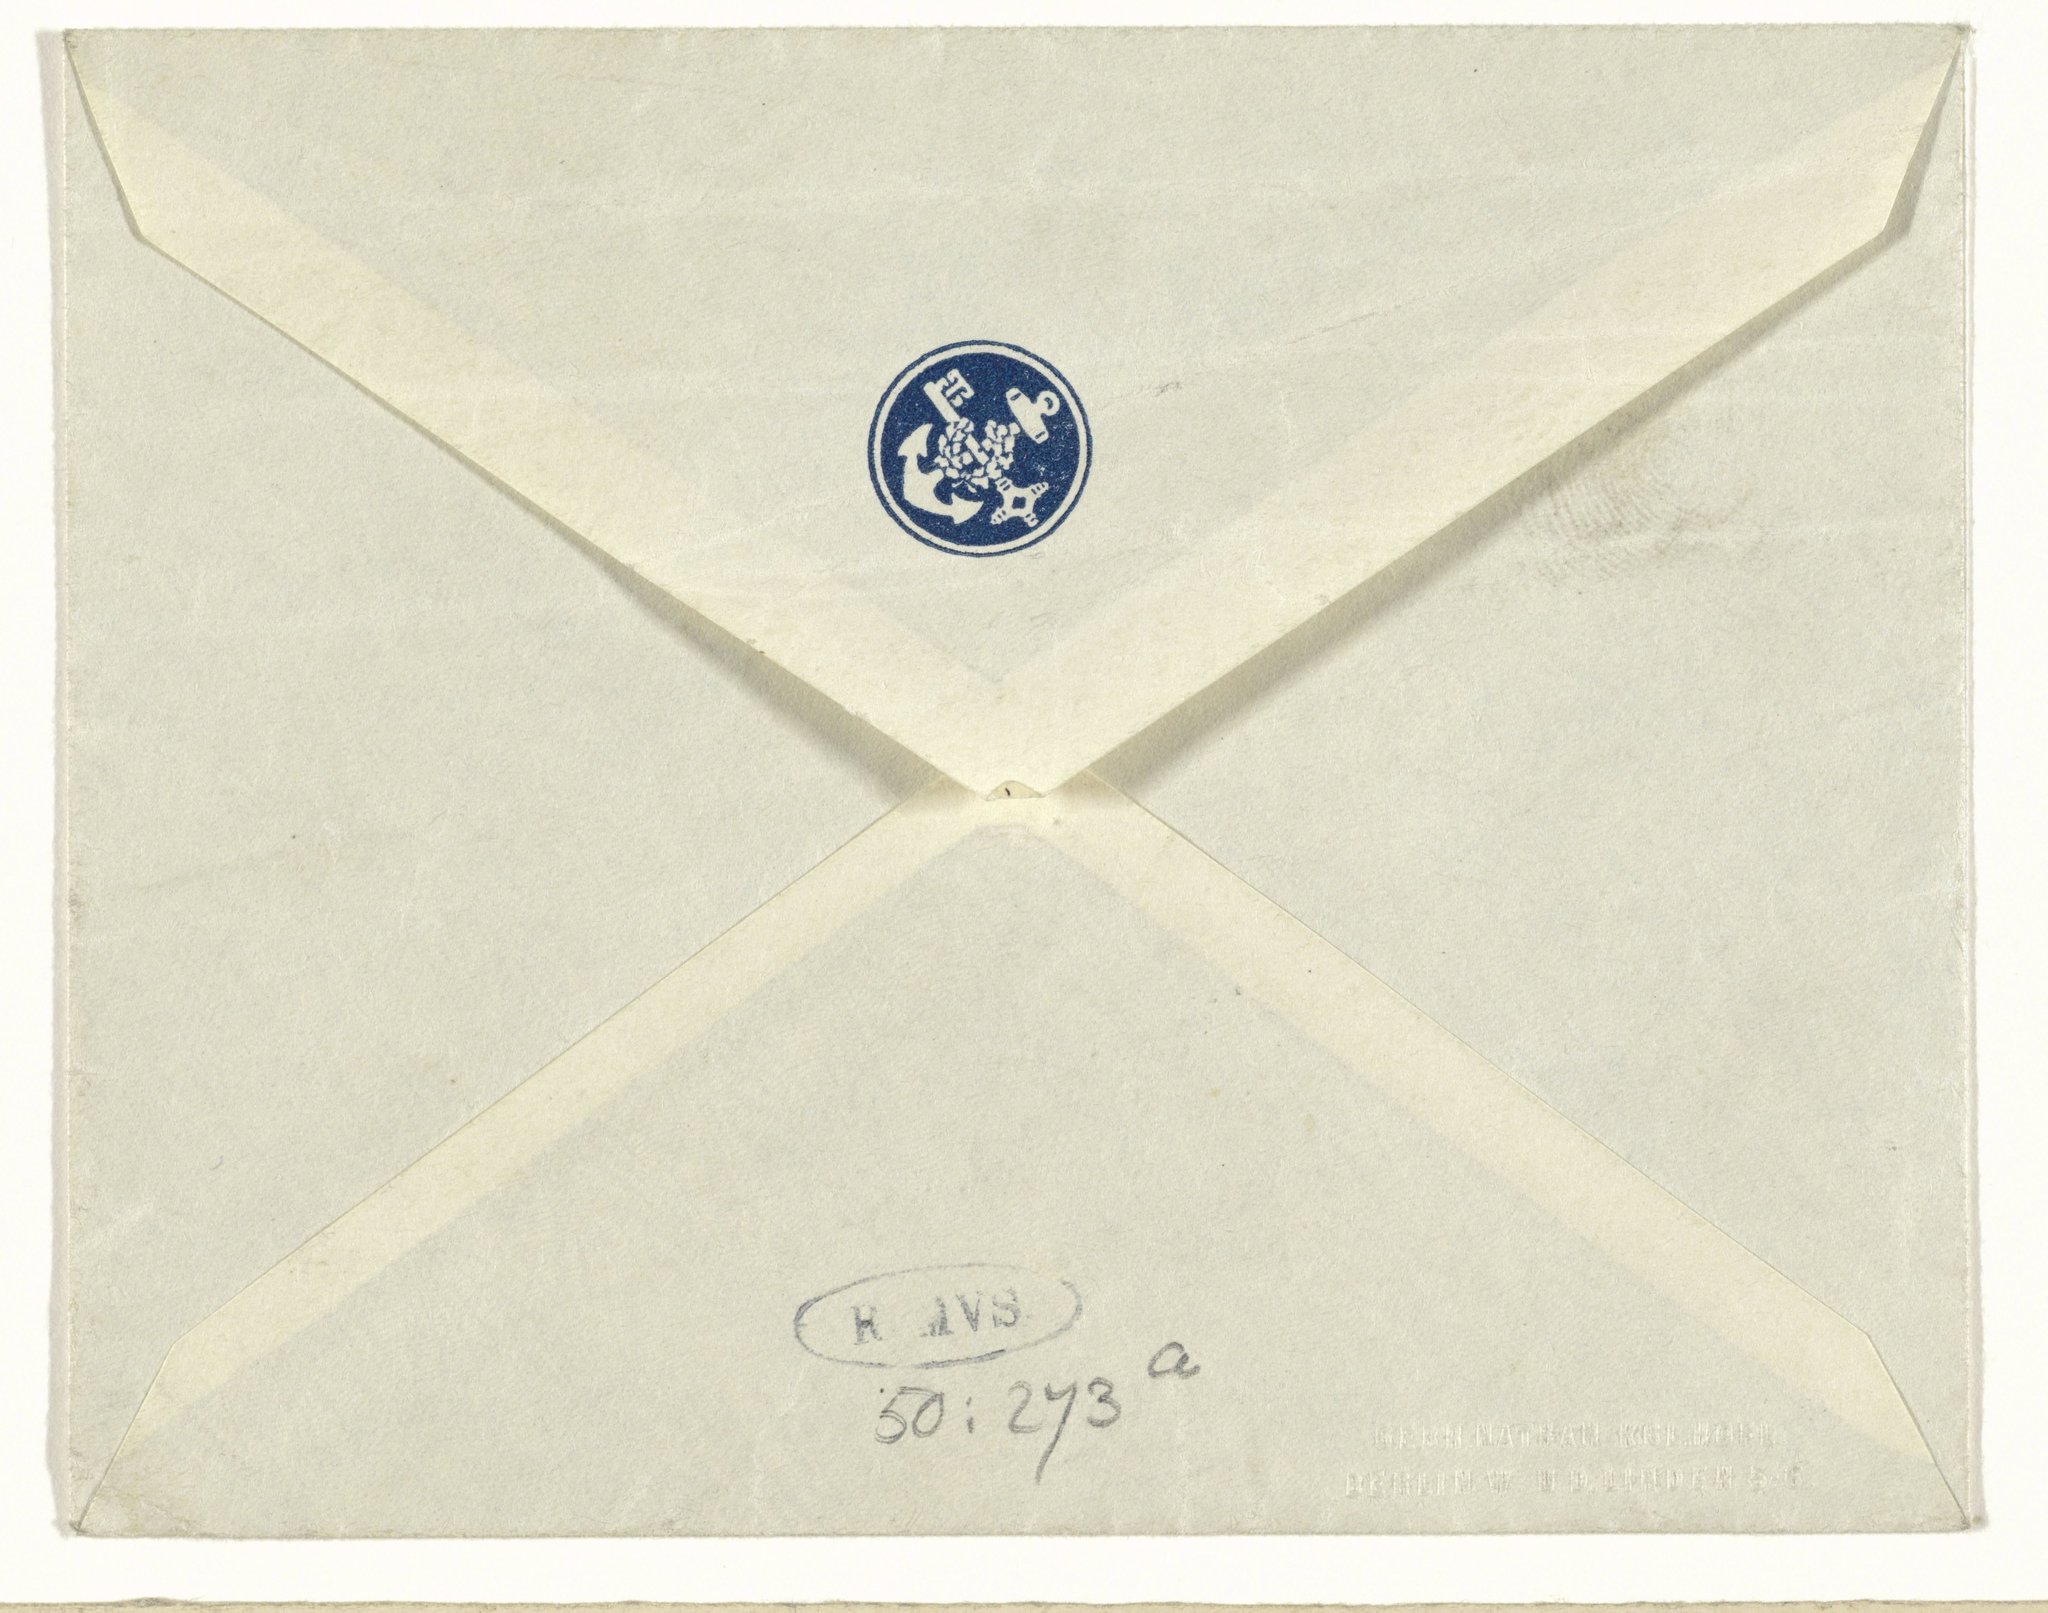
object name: design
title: Delen van ontwerp voor een horlogeketting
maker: mathieu lauweriks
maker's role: designer, draughtsman, print maker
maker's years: 1864-1932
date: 1874-1932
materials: paper, pencil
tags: ornaments, jewels, watch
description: Uitgeknipte delen van een ontwerp voor een horlogeketting. De losse knipsels worden bewaard in een envelop.